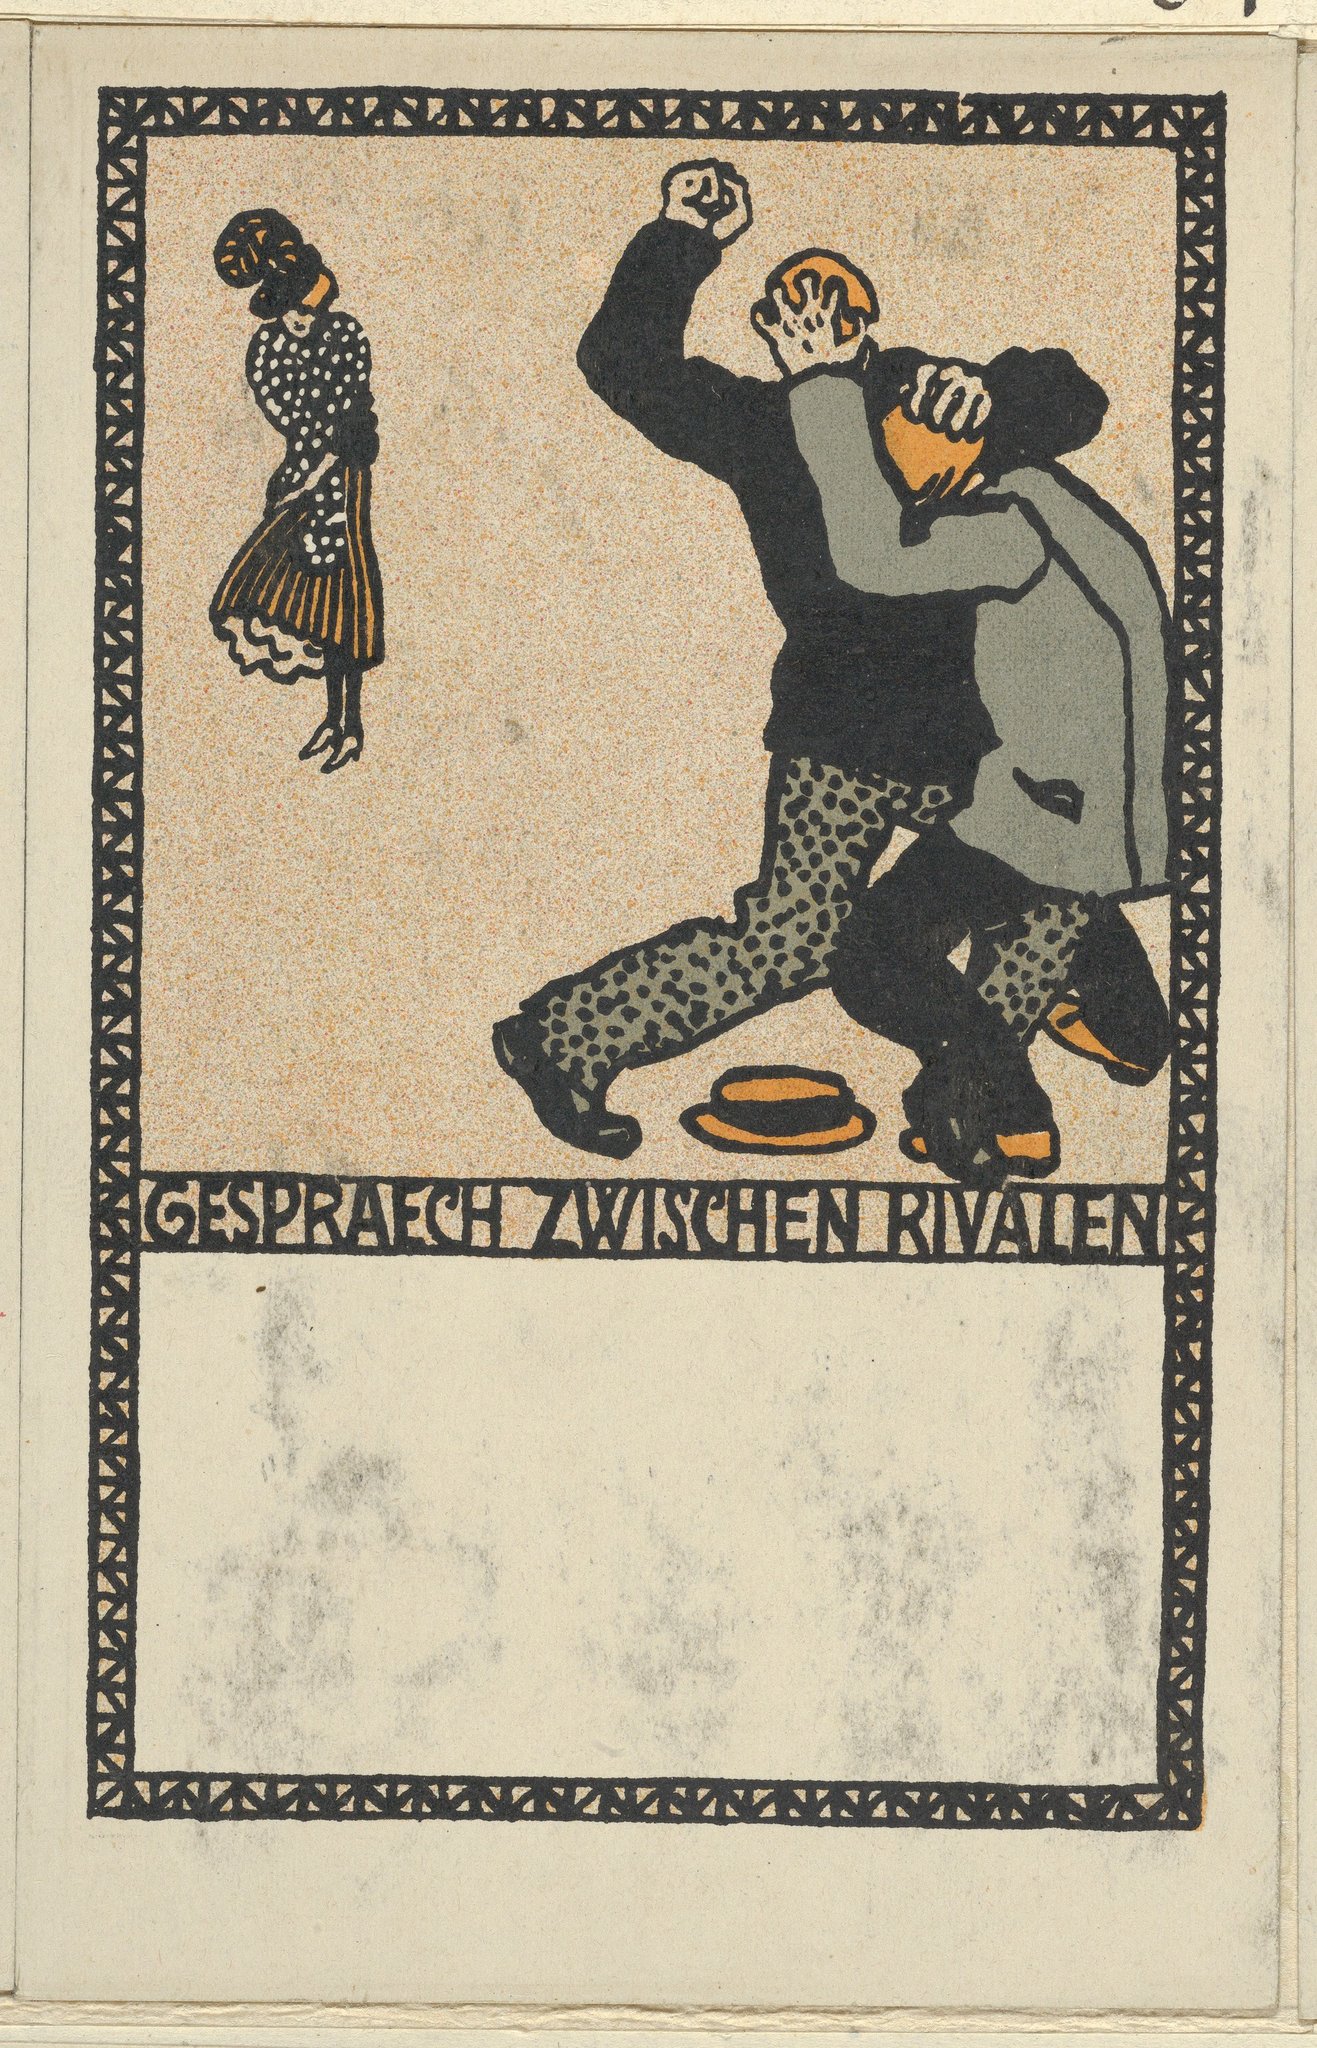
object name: print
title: Conversation Between Rivals (Gespraech Zwischen Rivalen)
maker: moriz jung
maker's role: artist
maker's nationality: austrian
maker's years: 1885-1915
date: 1907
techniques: lithograph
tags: men,women